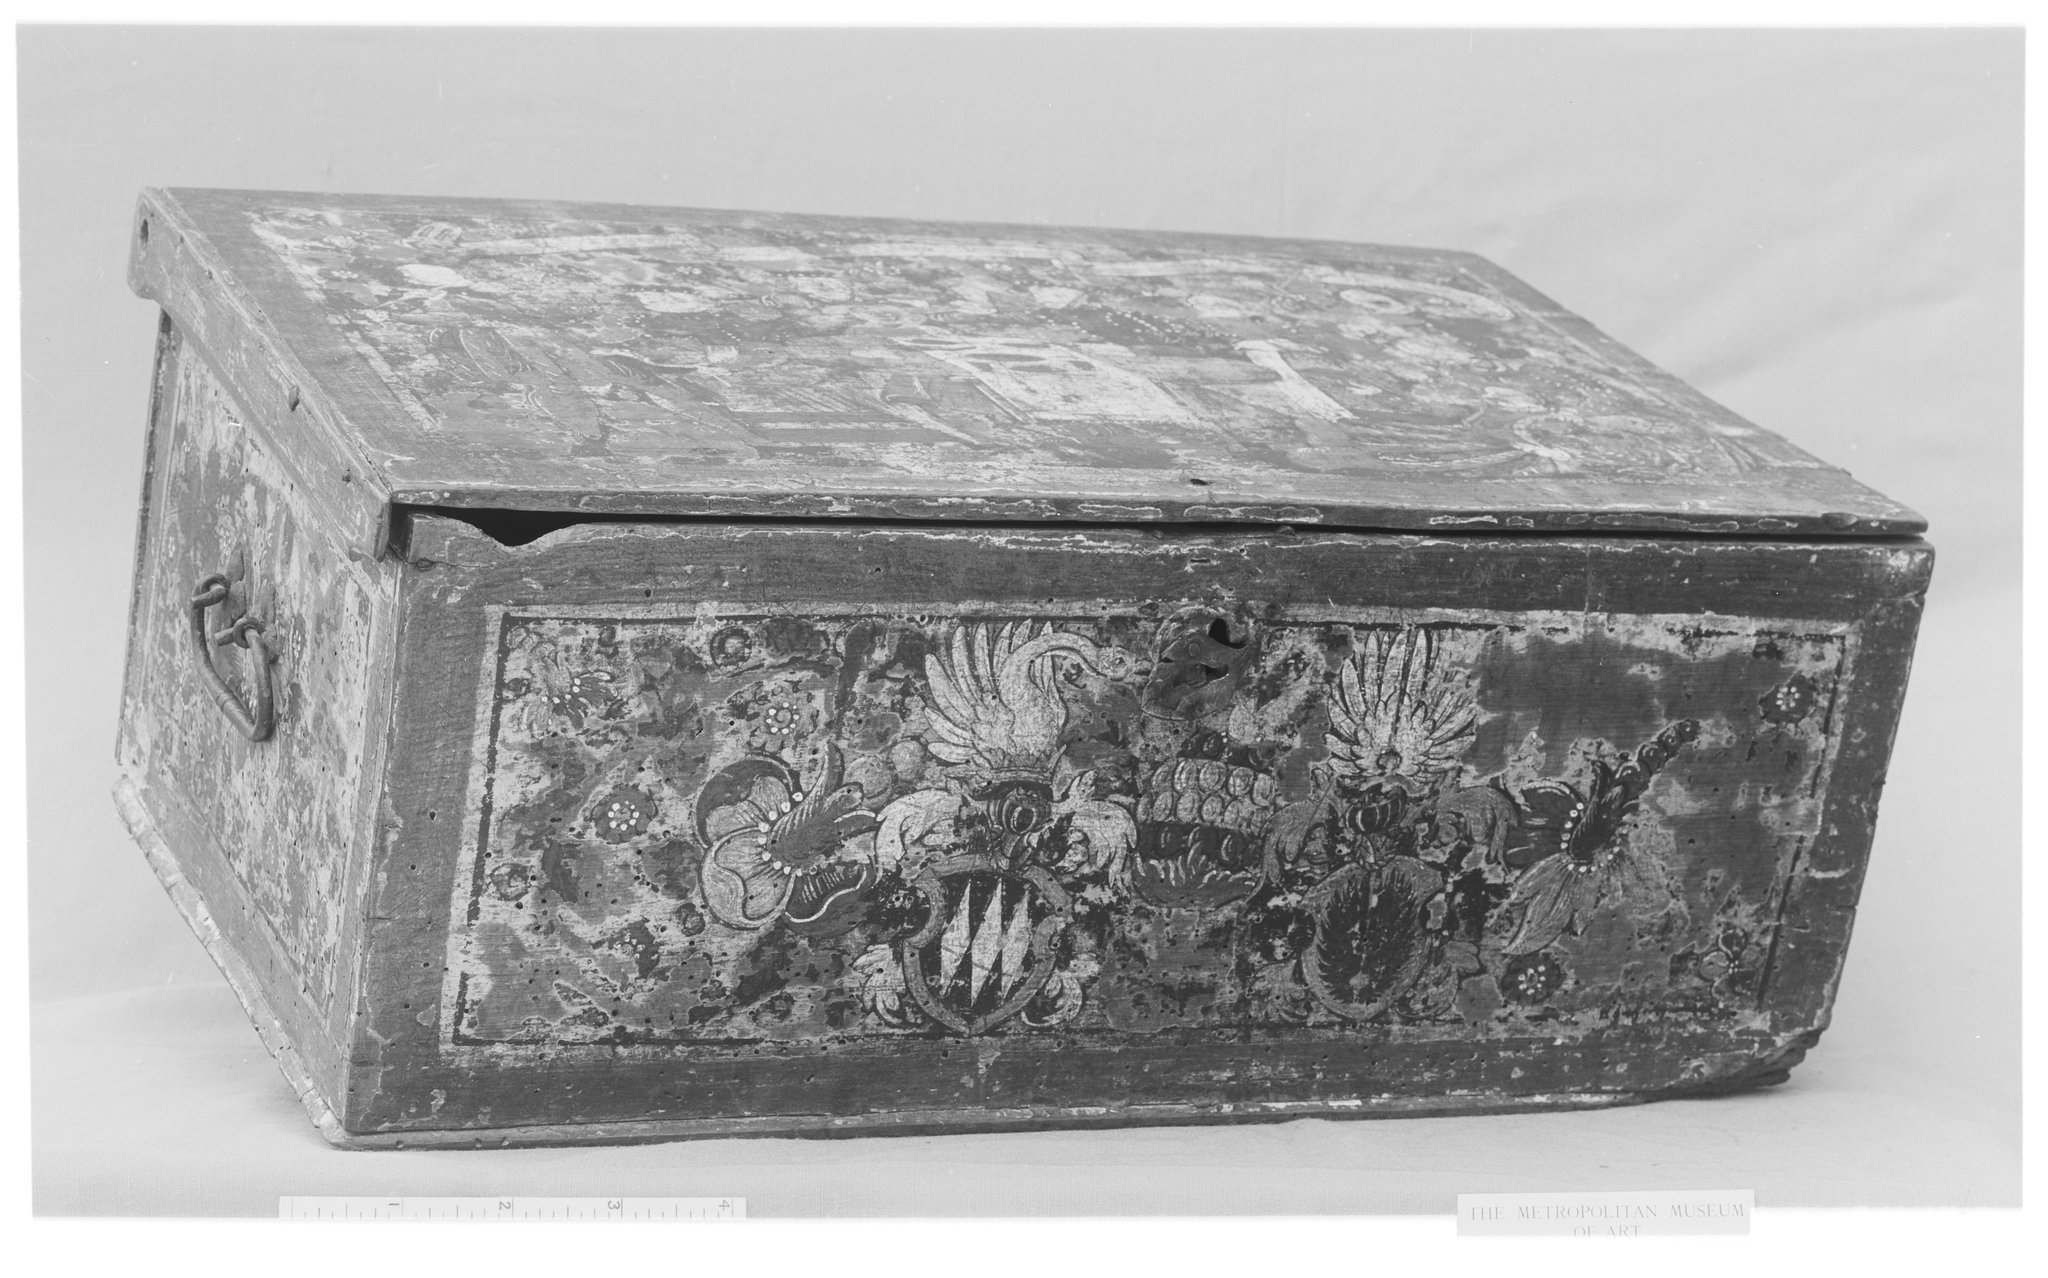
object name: box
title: Box with conjoined arms of Bonstetten (Switzerland) and Jung (Strasbourg)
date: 1501-1600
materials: wood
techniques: painting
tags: flowers,coat of arms